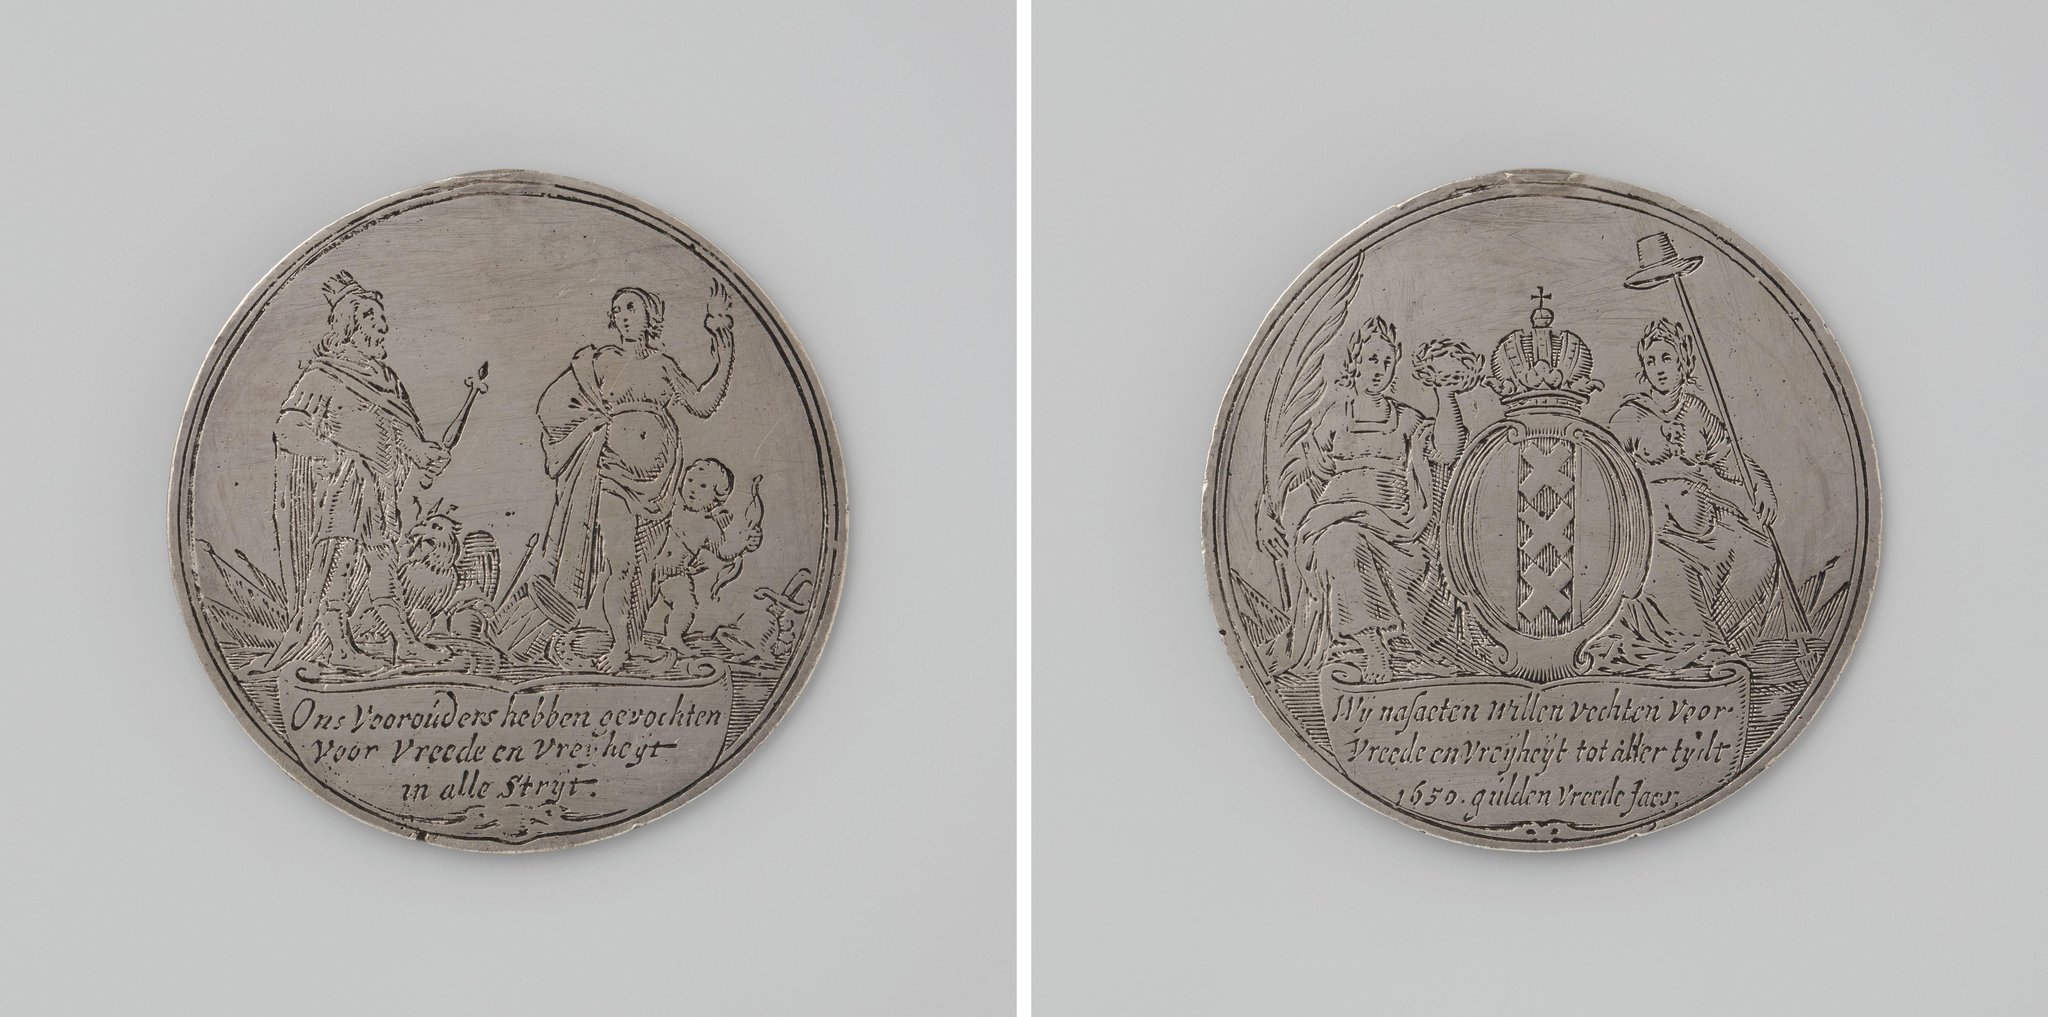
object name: history medal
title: Beleg van Amsterdam door Willem II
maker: Anonymous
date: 1650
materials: silver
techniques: casting, engraving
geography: amsterdam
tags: william ii (prince of orange), amsterdam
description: Zilveren penning. Voorzijde: Jupiter, Venus en Amor staande temidden van krijgstuig boven opschrift. Keerzijde: Vrede met palmtak en lauwerkrans en Vrijheid met vrijheidshoed op speer zittend naast gekroond wapenschild van Amsterdam boven opschrift